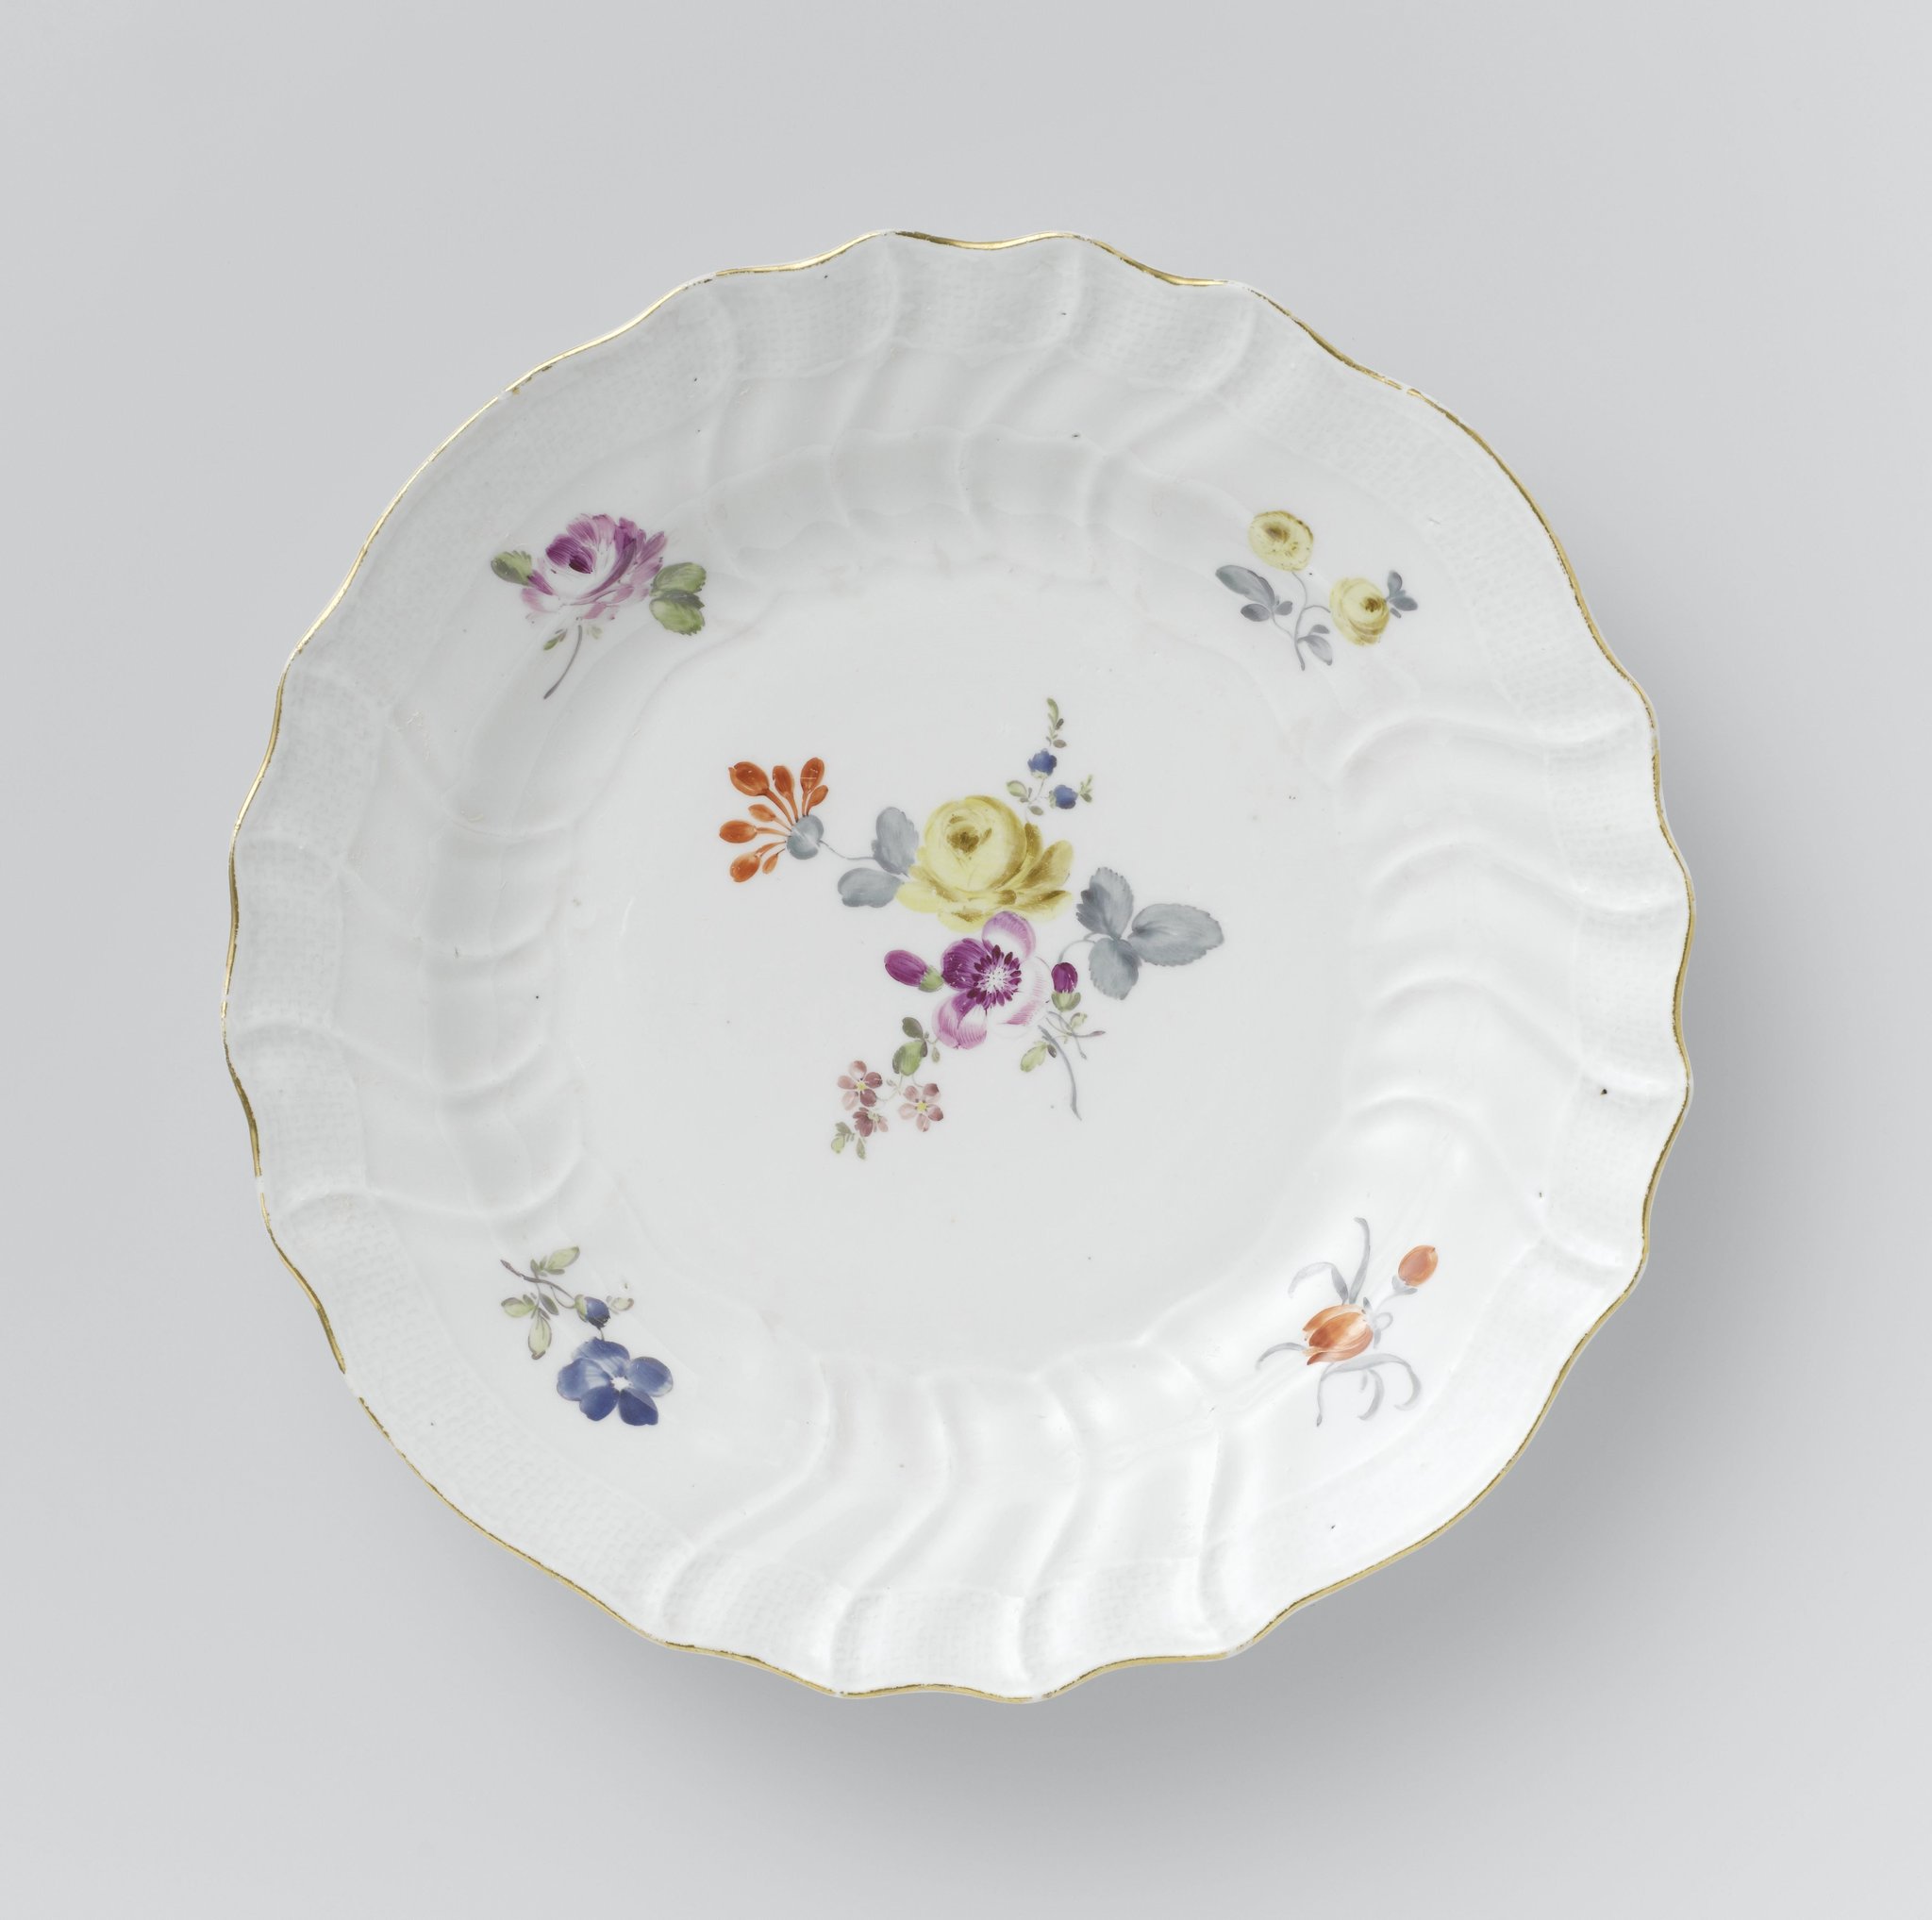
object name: eating drinking utensil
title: Bord, veelkleurig beschilderd met Deutsche Blumen, insekten en vruchten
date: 1750-1760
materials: porcelain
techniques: painted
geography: meissen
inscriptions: factory mark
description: Rond bord van beschilderd porselein. De rand is versierd met het Neuozier-patroon. De beschildering bestaat uit Deutsche Blumen, insekten en vruchten. Het bord is gemerkt en hoort bij een servies (BK-17474-1 t/m BK-17474-253).